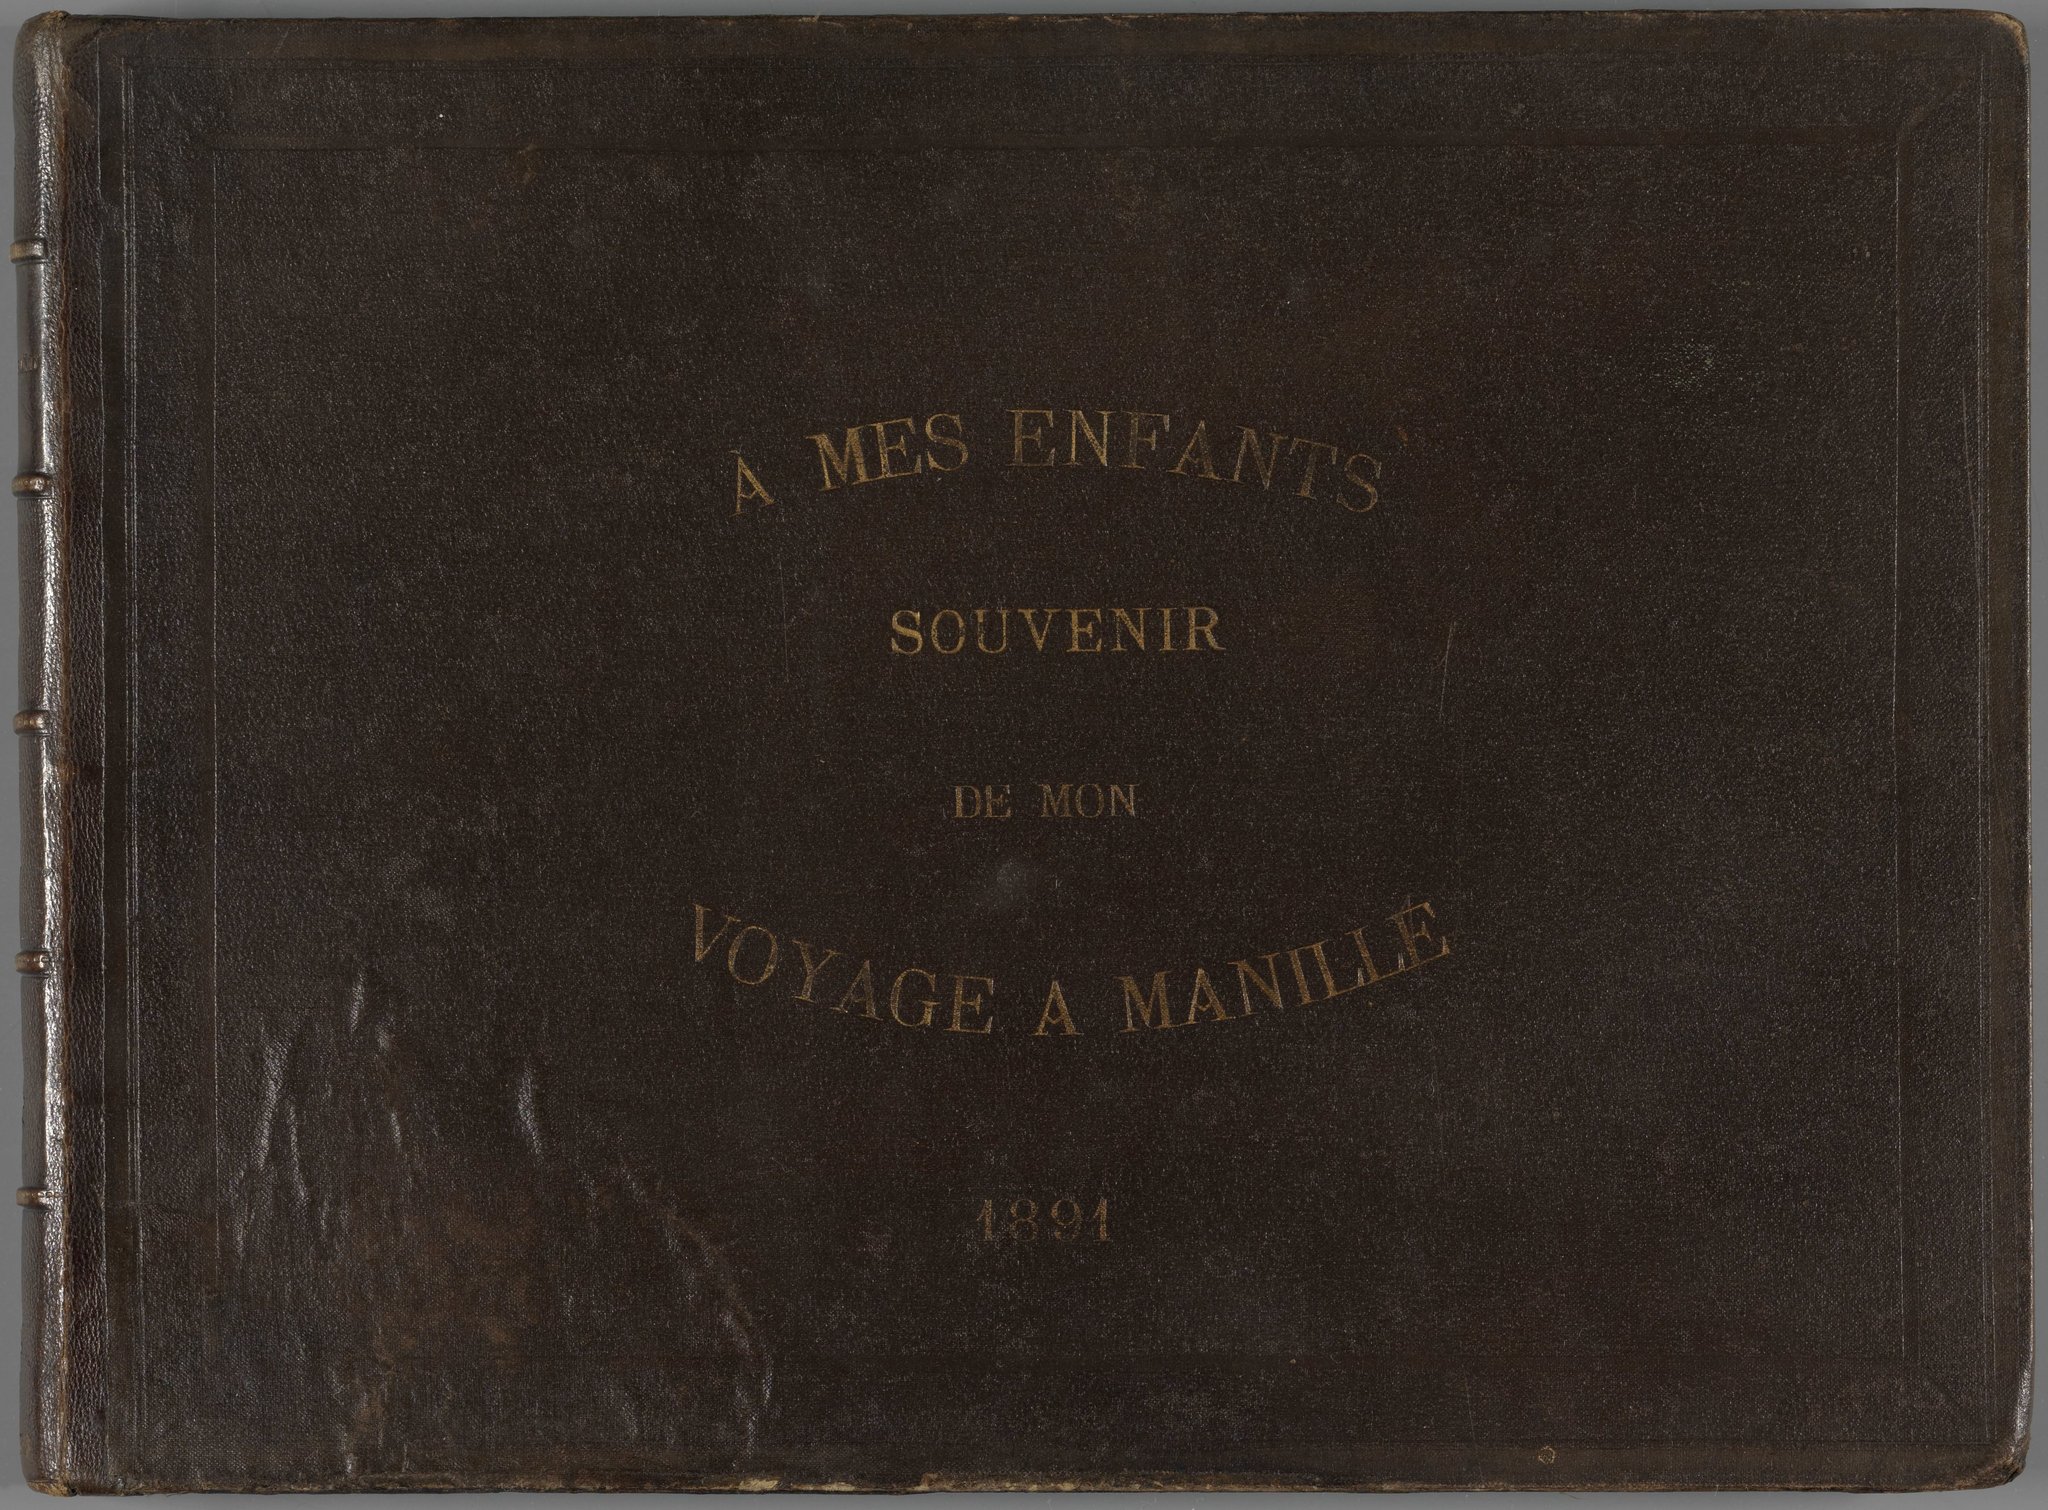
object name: scrapbook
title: Fotoalbum van een reis naar Manilla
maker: Anonymous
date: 1891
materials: cardboard, leather, linen, paper, photographic support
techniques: albumen print, marbling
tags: travelling; tourism, japan, philippines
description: Fotoalbum in bruine band. Op de bandrug, die versierd is met een bloemmotief in blinddruk, staan onderaan de letters 'A.F.' en bovenaan de plaatsnaam 'Port-Saïd'. De schutbladen zijn van gemarmerd sierpapier. Het album bevat 32 bladen met 52 foto's en 1 tekening. Het zijn voornamelijk opnames gemaakt in Egypte, Turkije, Japan en de Filipijnen, waaronder stads-, dorps-, haven- en straatgezichten, landschappen en studioportretten van lokale bevolking.